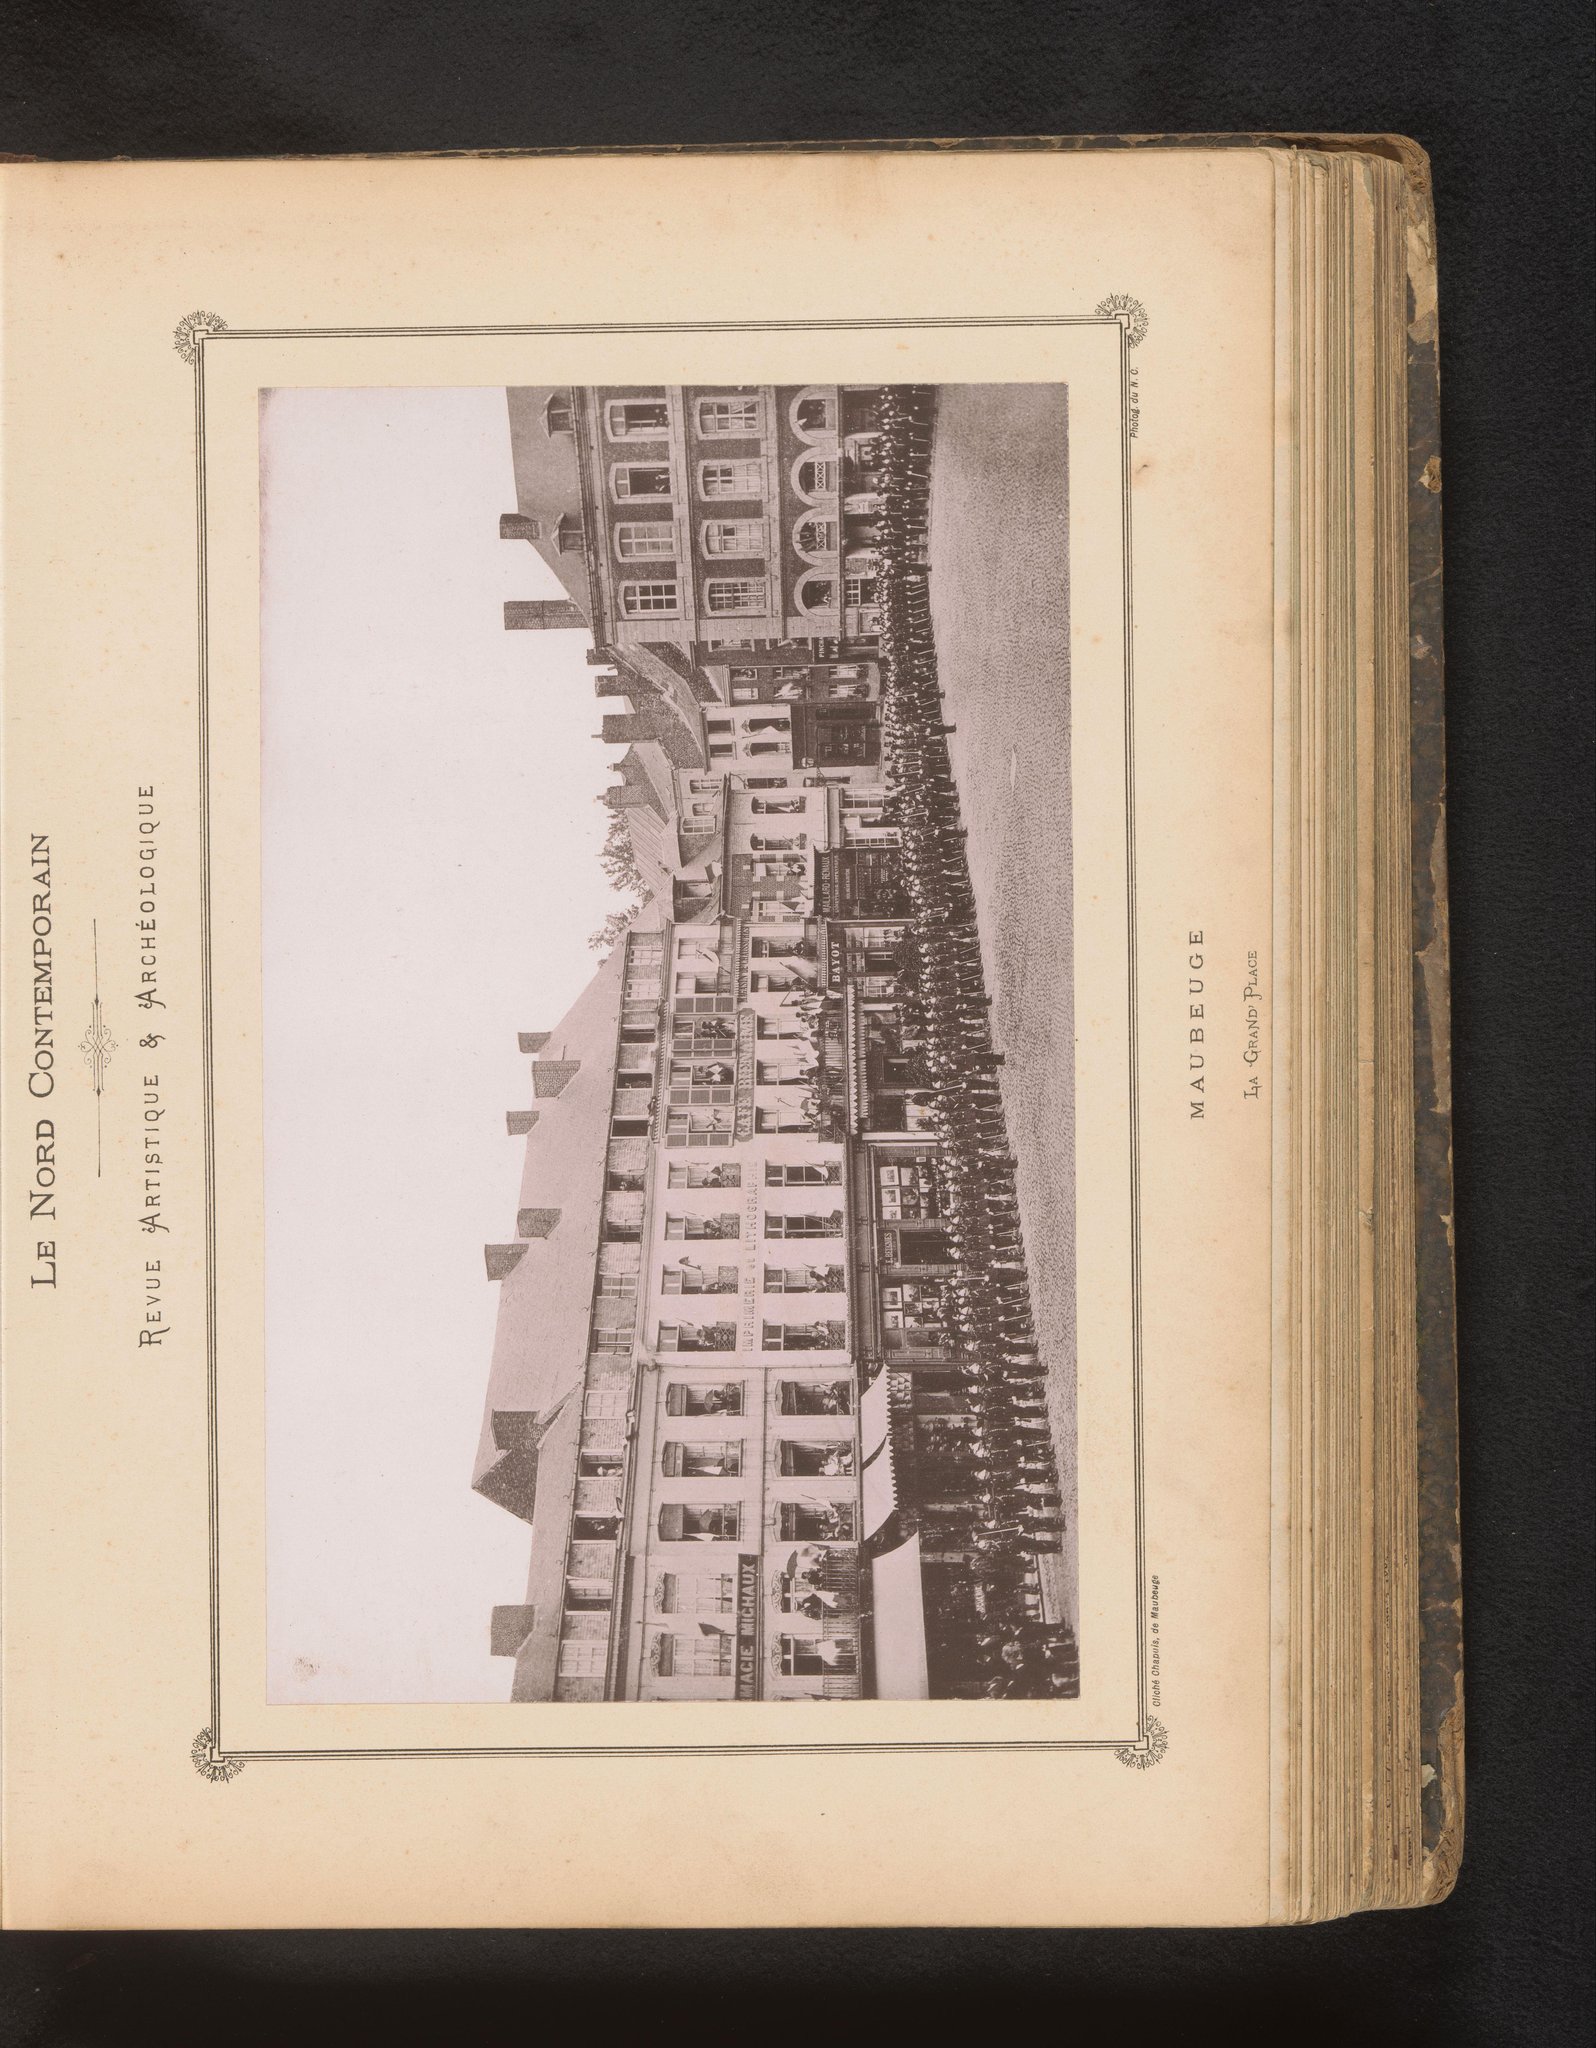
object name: photomechanical print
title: Gezicht op het Grand'Place in Maubeuge, Frankrijk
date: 1877-1882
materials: paper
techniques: photograph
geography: maubeuge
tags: square, place, circus, etc.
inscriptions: inscription: ‘Le Nord Contemporain/ Revue Artistique & Archéologique’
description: Prent op vijfde ongenummerde pagina na pagina 368.